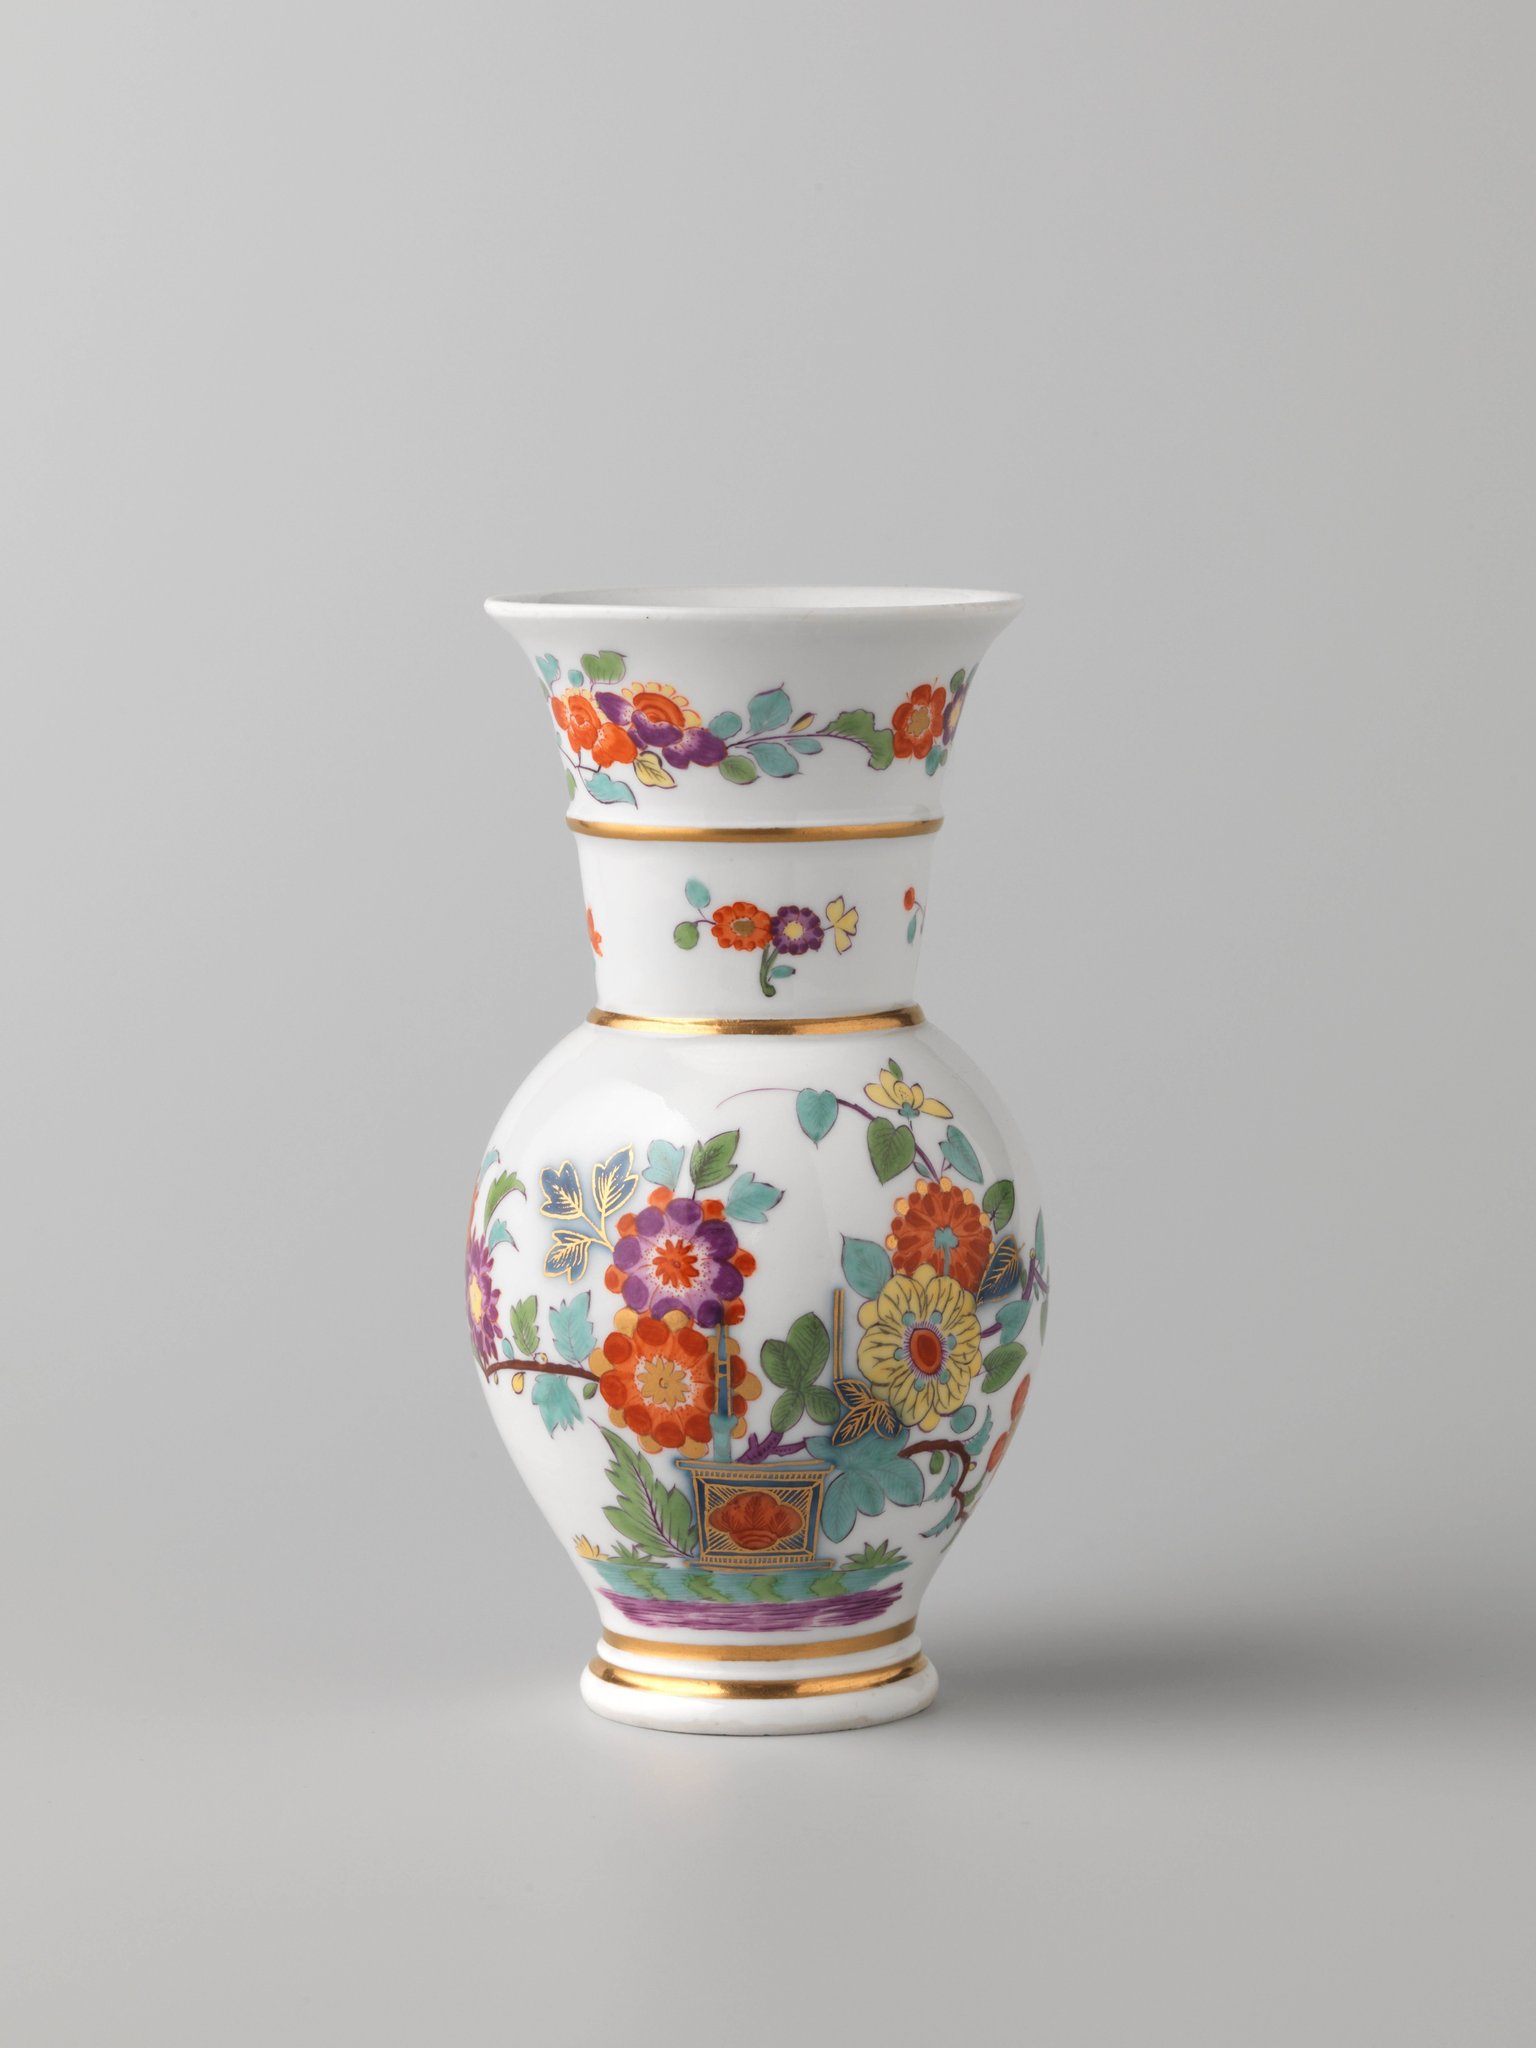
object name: vase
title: Vaas, veelkleurig beschilderd met Indianische Blumen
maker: johann daniel rehschuh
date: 1730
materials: porcelain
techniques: painted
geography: meissen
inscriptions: mold mark: ‘X (Rückert 1996, afb. 6, nr. 33)’, factory mark: ‘AR’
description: Two vases. Porcelain. Meissen, c. 1730.